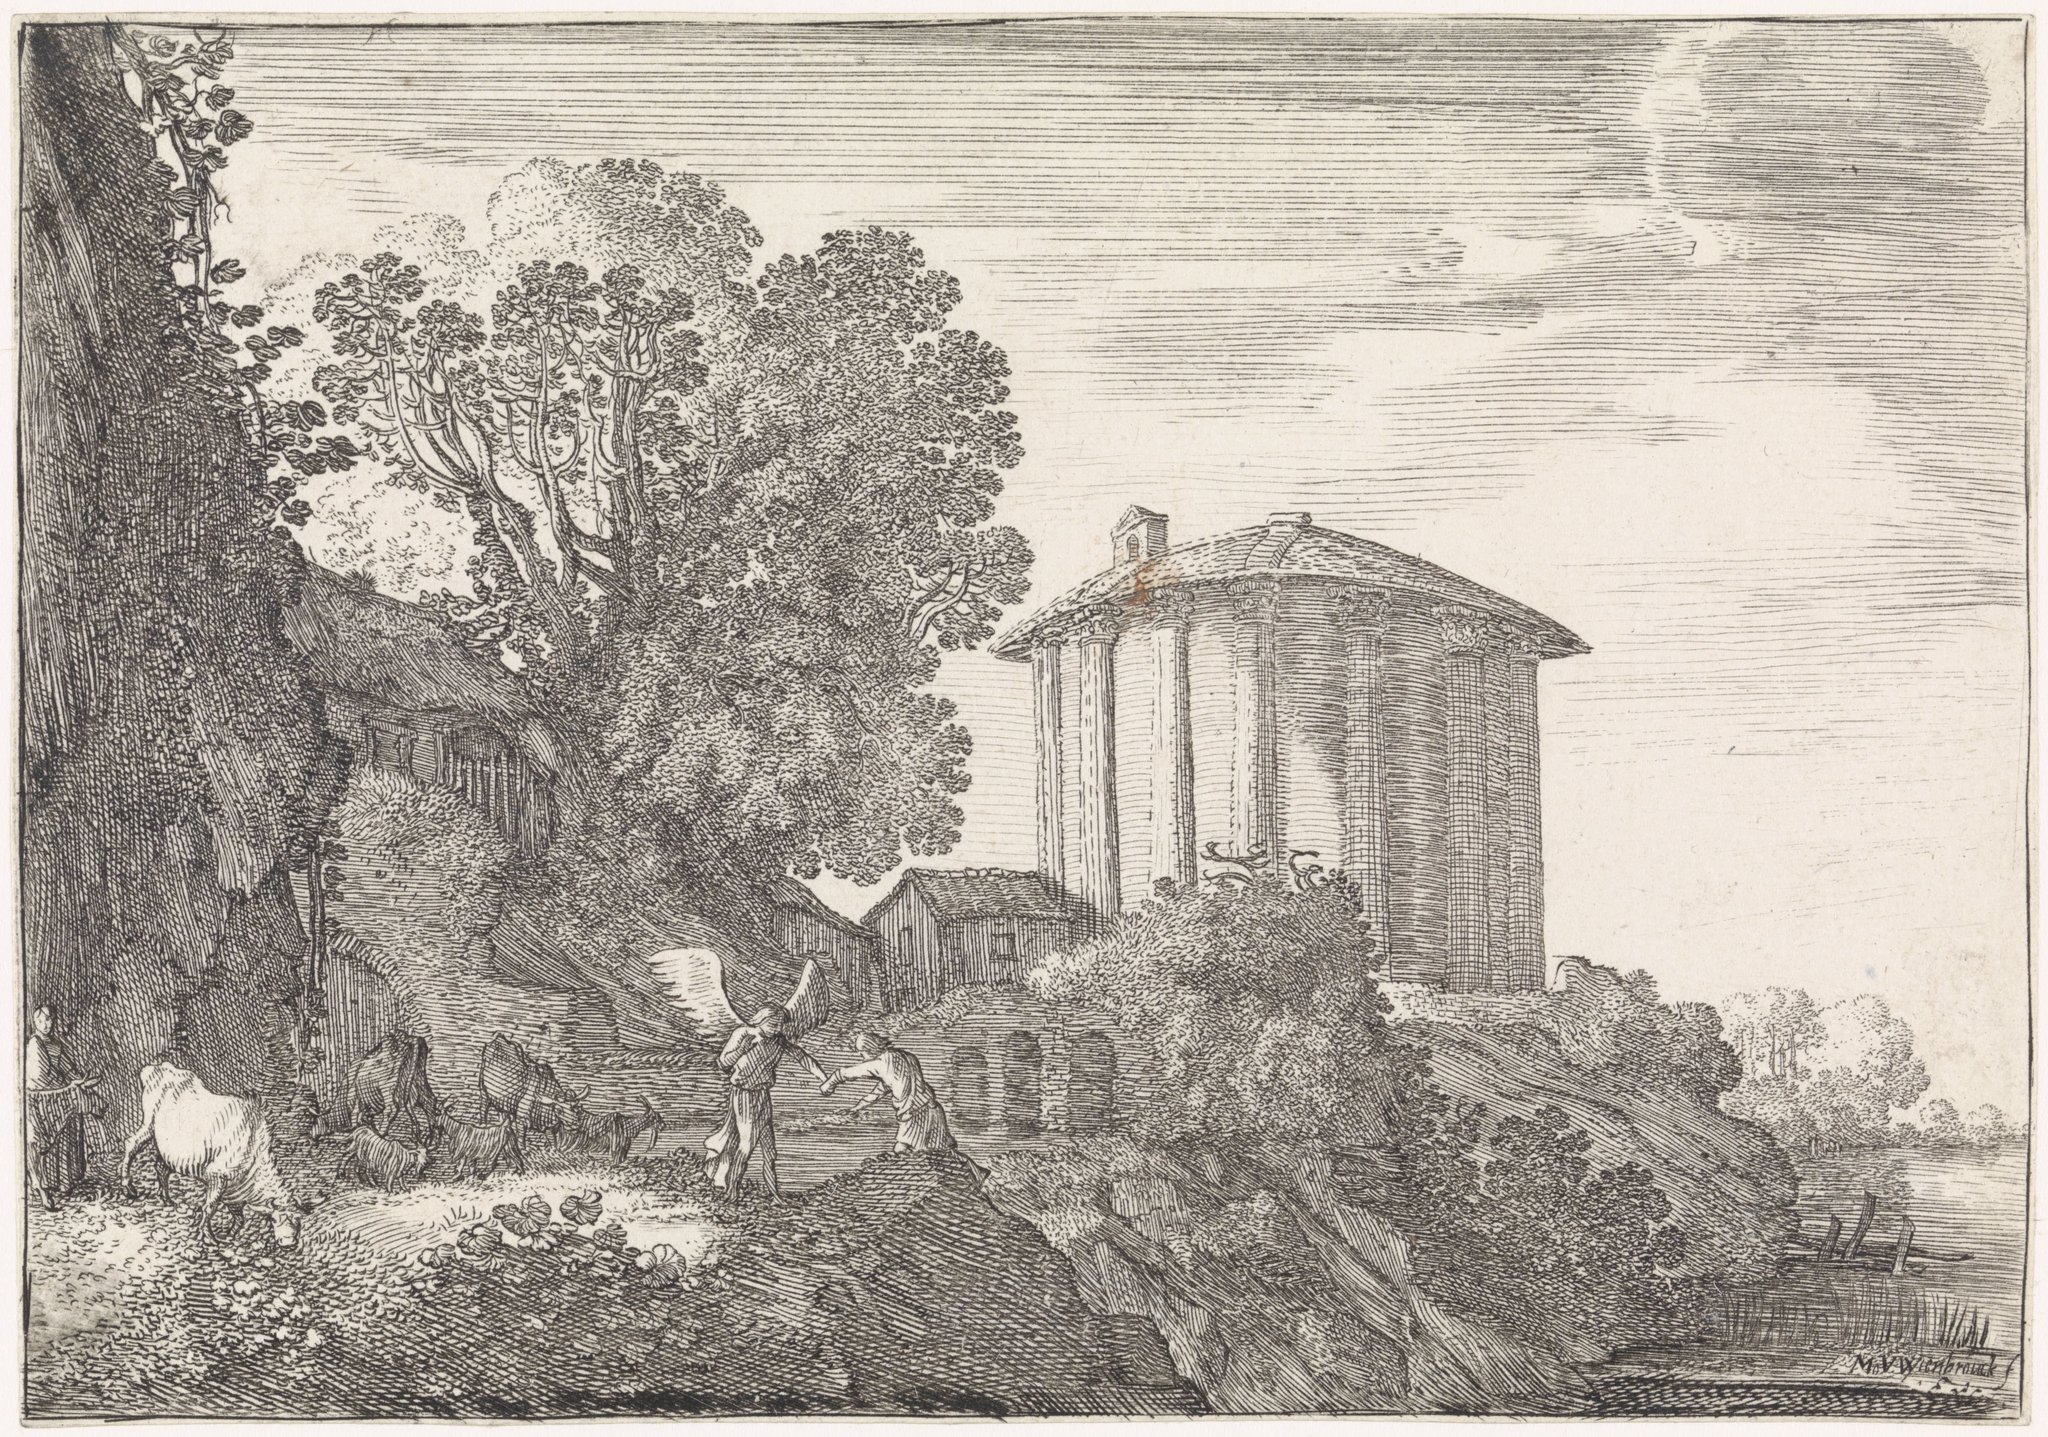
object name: print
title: Arcadische landschappen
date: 1600-1647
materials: paper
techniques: engraving, etching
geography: amsterdam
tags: the meeting of tobias and the angel raphael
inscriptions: collector's mark: Lugt 2228, collector's mark: Lugt 2610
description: In een landschap met een ronde, klassieke tempel houdt een engel een man bij de hand (Tobias en de engel?). Links een herderin met haar kudde.